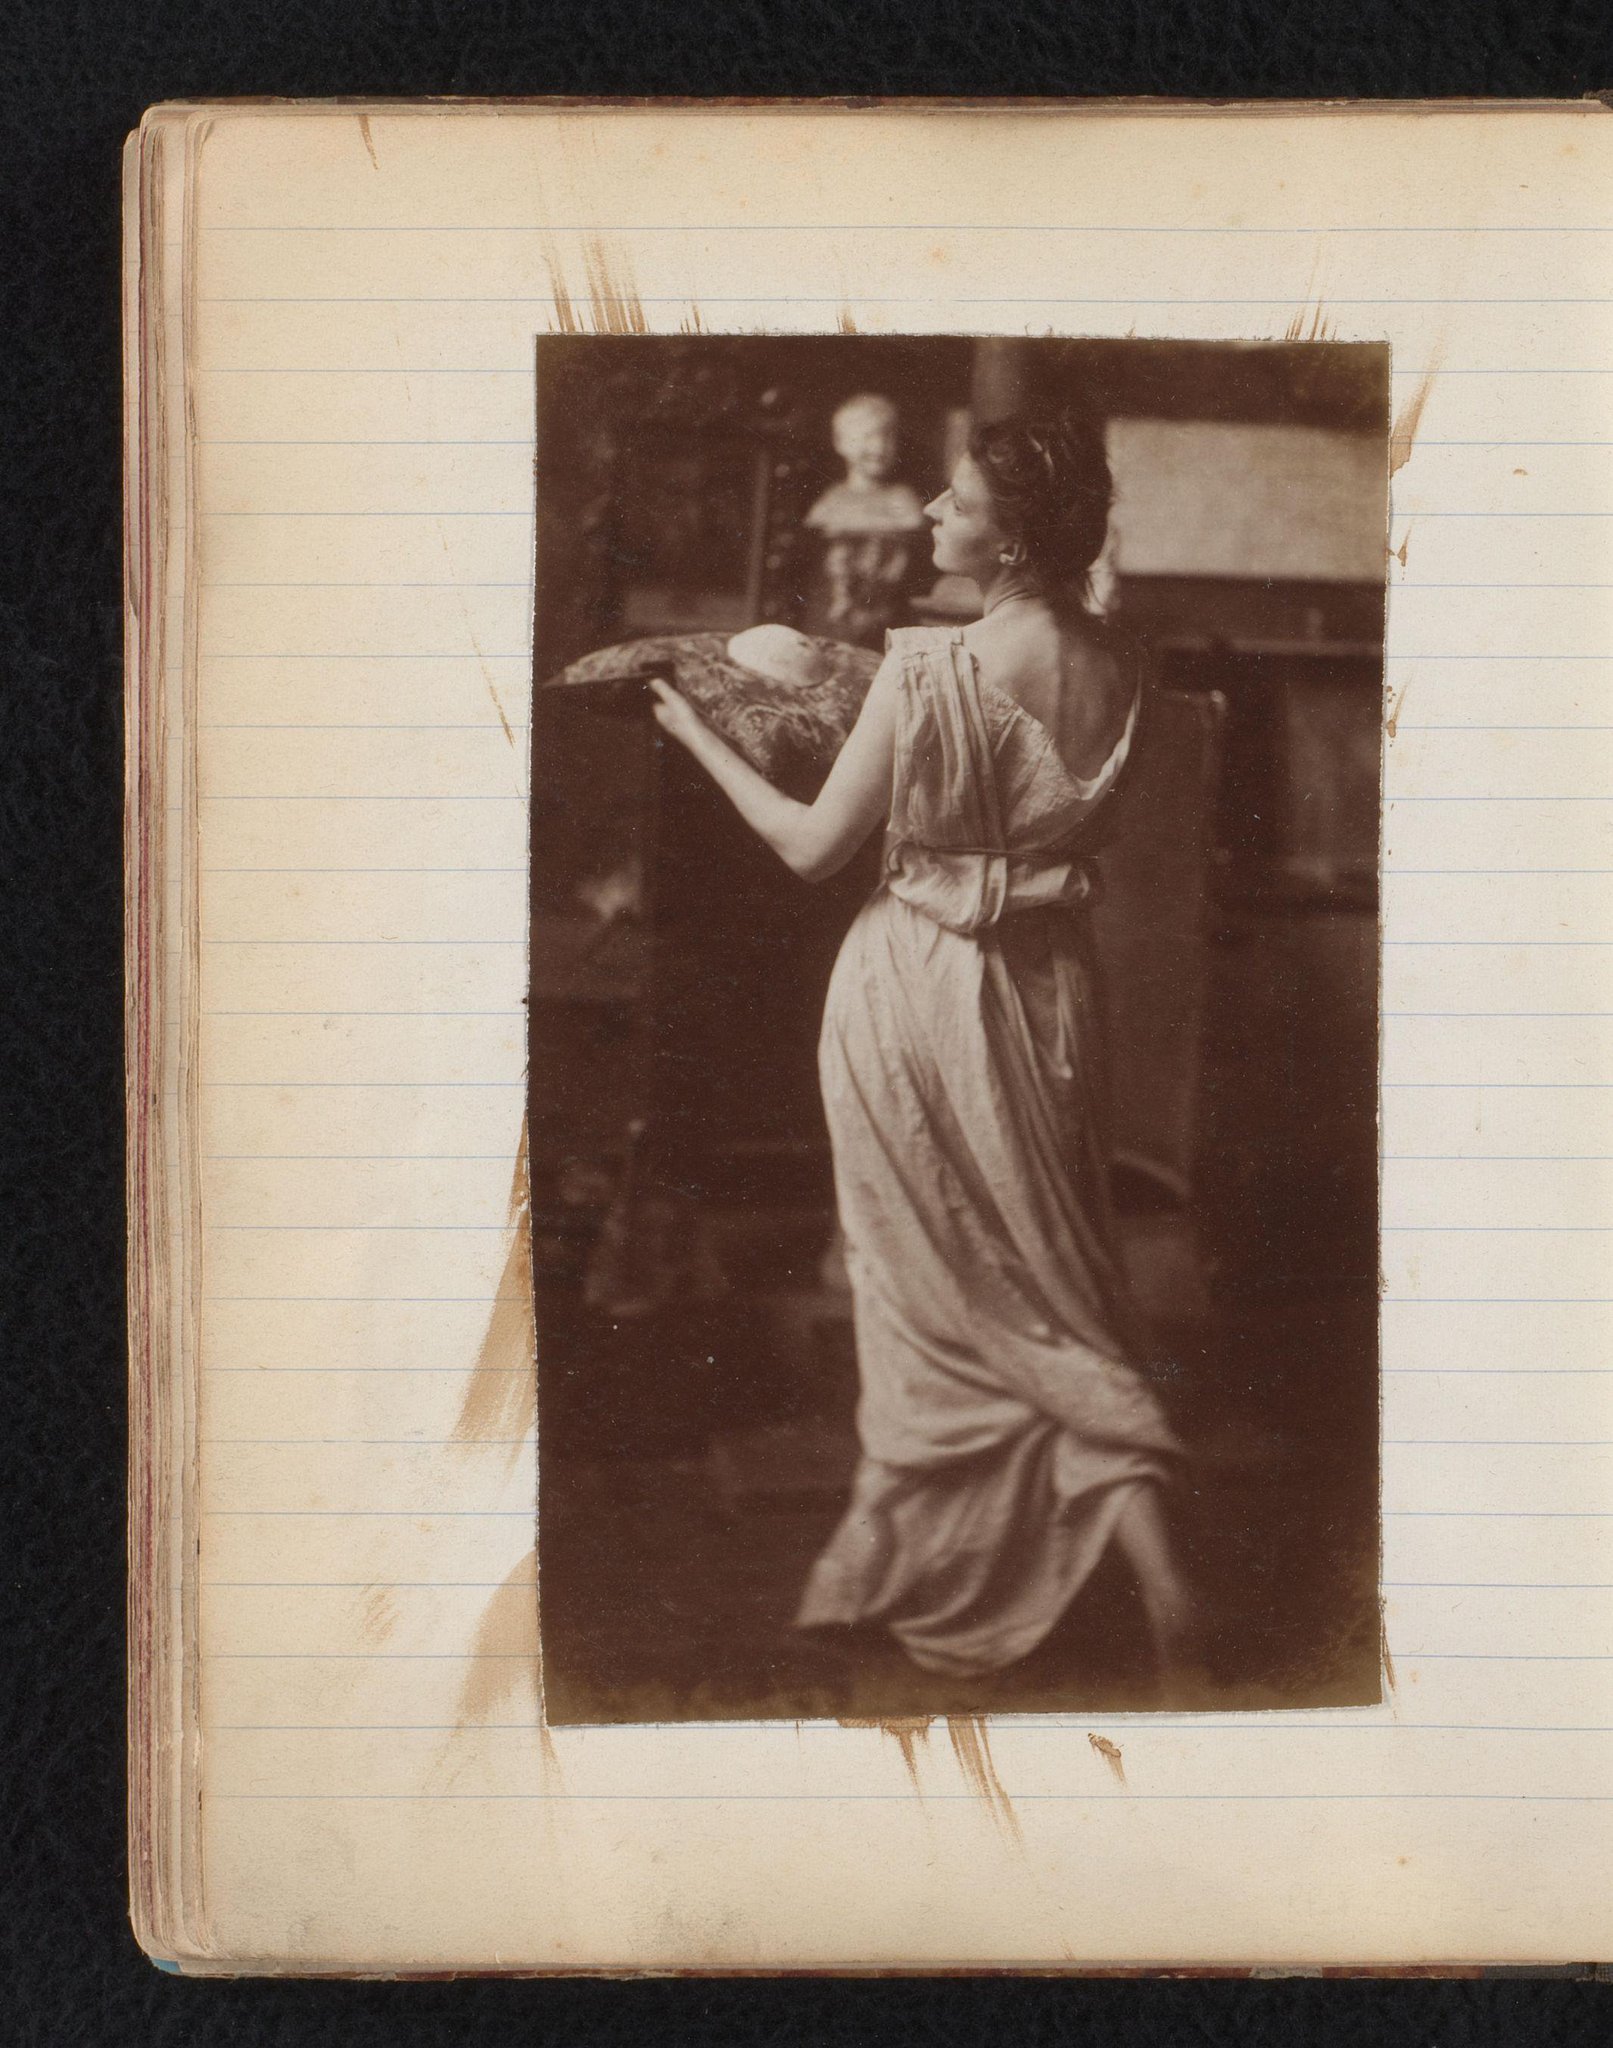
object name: photograph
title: Studie van een vrouwelijk model in draperie, op de rug gezien, in het atelier van Jacques de Lalaing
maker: jacques lalaing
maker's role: painter, sculptor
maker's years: 1858-1917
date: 1883-1914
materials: photographic support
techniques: albumen print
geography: brussels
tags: adult woman, artist (in general) working from nude model, the (nude) human figure; 'corpo humano' (ripa) (+ back view)